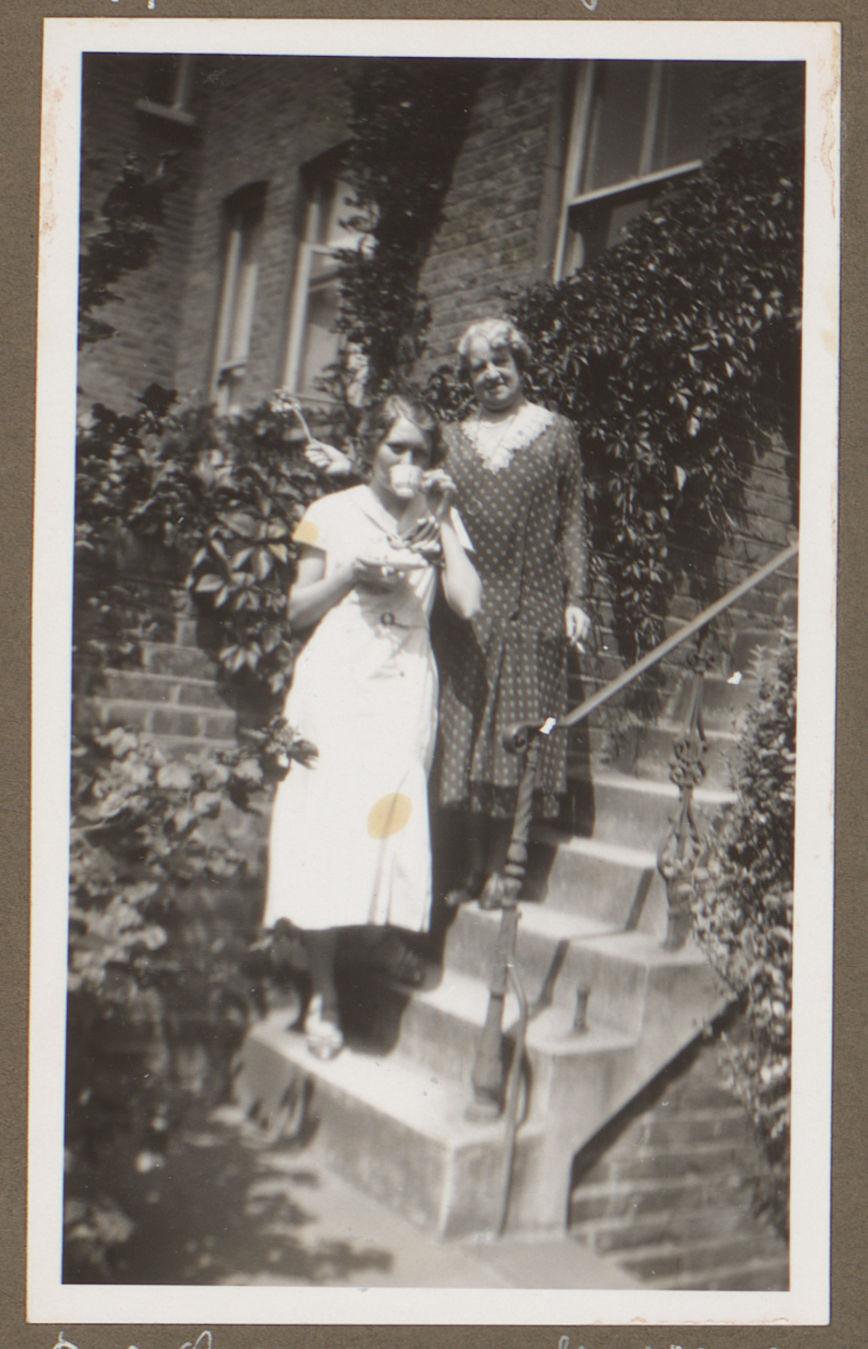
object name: photograph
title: Portret van Beh Oudemans en mevrouw Fletcher-Porter, Londen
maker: Anonymous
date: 1906-1933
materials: paper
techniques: gelatin silver print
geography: london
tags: historical persons - bb - woman, london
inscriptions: inscription: ‘49 Lexham Gardens’, inscription: ‘Beh Oudemans - Mrs. Fletcher/ Porter’